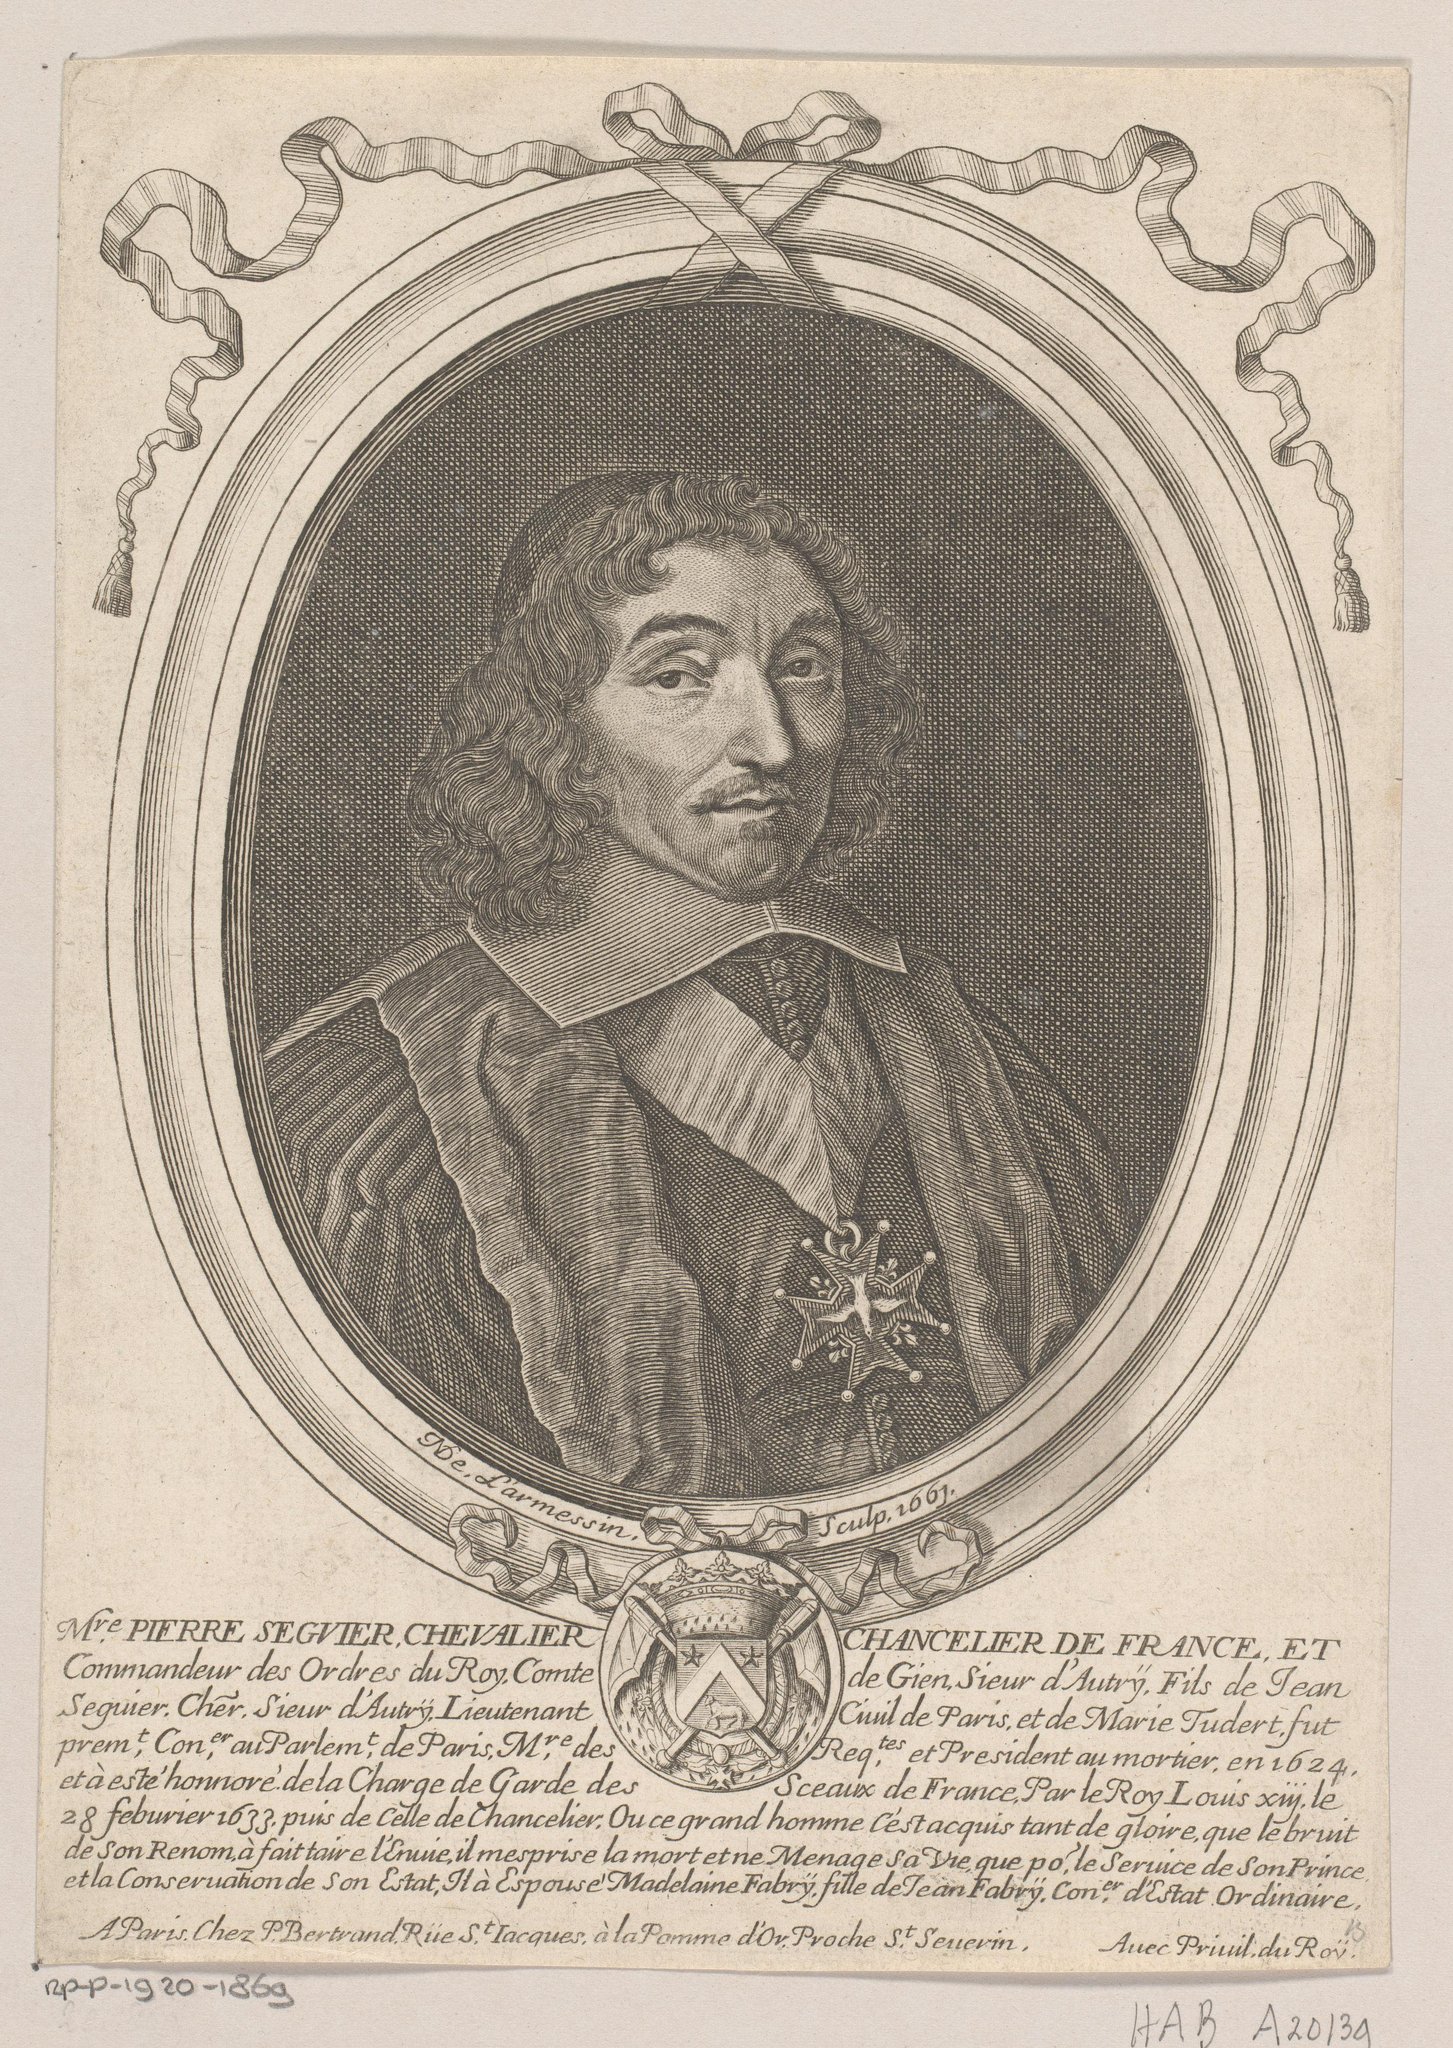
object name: print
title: Portret van Pierre Séguier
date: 1661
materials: paper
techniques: engraving, etching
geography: france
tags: pierre séguier, official; civil servant; functionary (in general), historical persons, politician, e.g. party leader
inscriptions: collector's mark: Lugt 2228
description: Met achtregelig onderschrift in twee kolommen in het Frans.